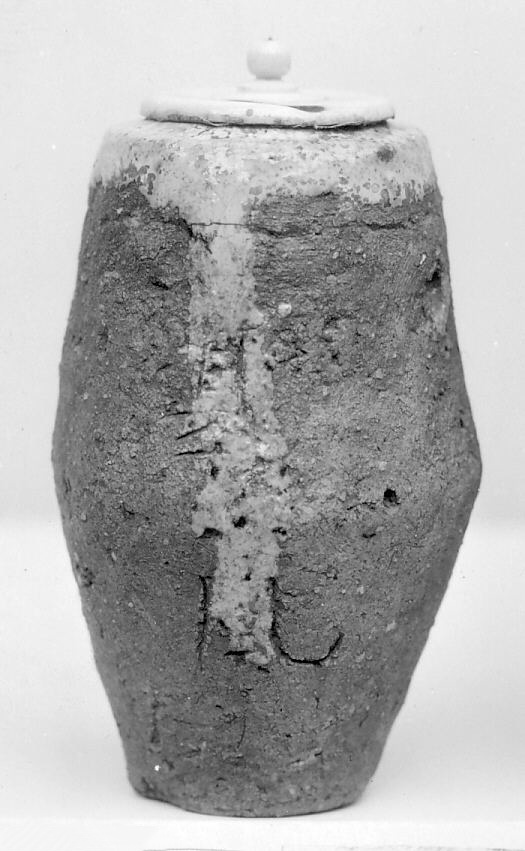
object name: tea jar with cover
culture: japanese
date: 1801-1900